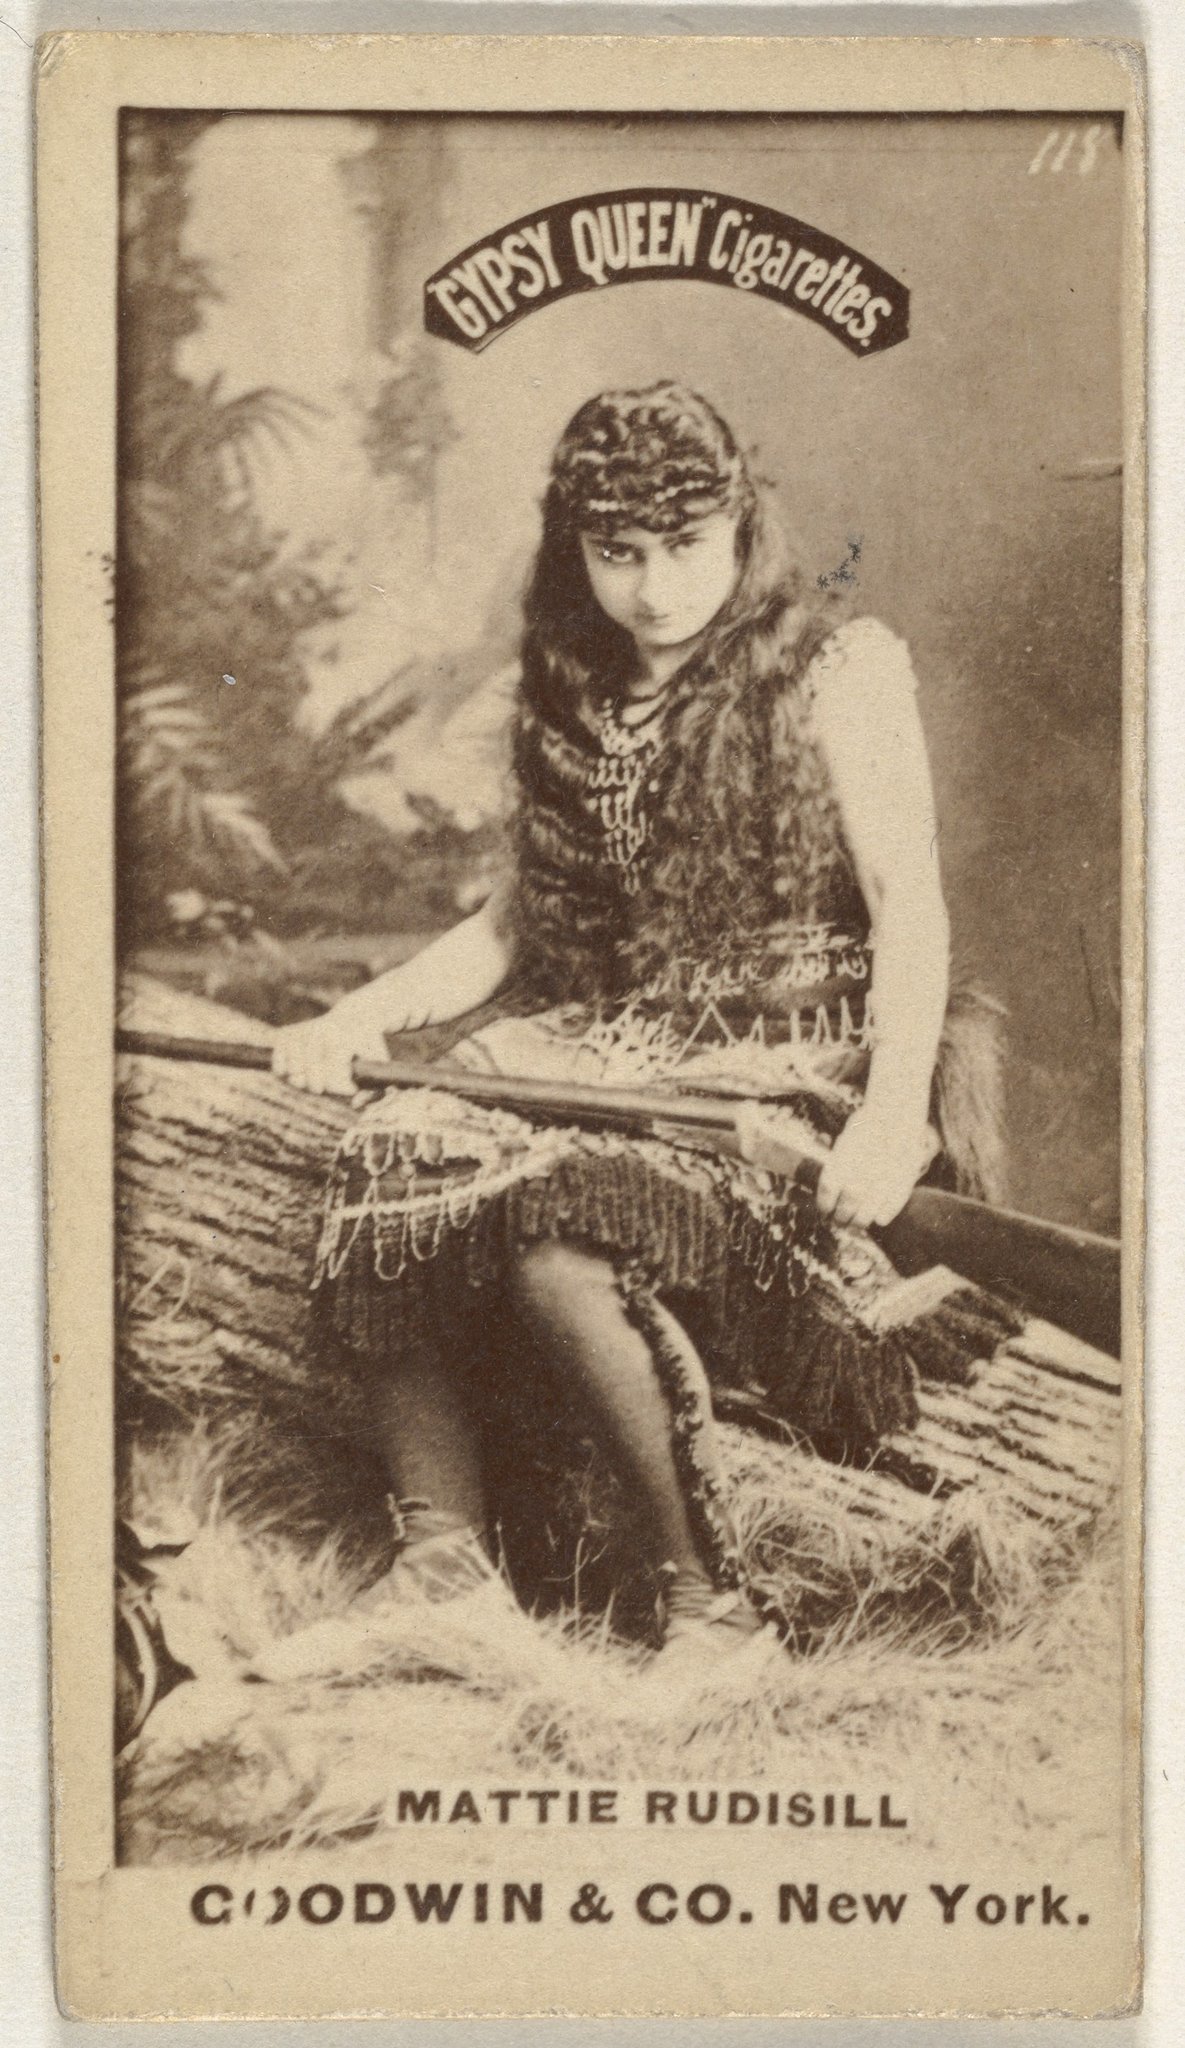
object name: photograph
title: Mattie Rudisill, from the Actors and Actresses series (N171) for Gypsy Queen Cigarettes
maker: goodwin & company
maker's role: publisher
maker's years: 1850-1950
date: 1886-1890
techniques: albumen silver print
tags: firearms,portraits,women